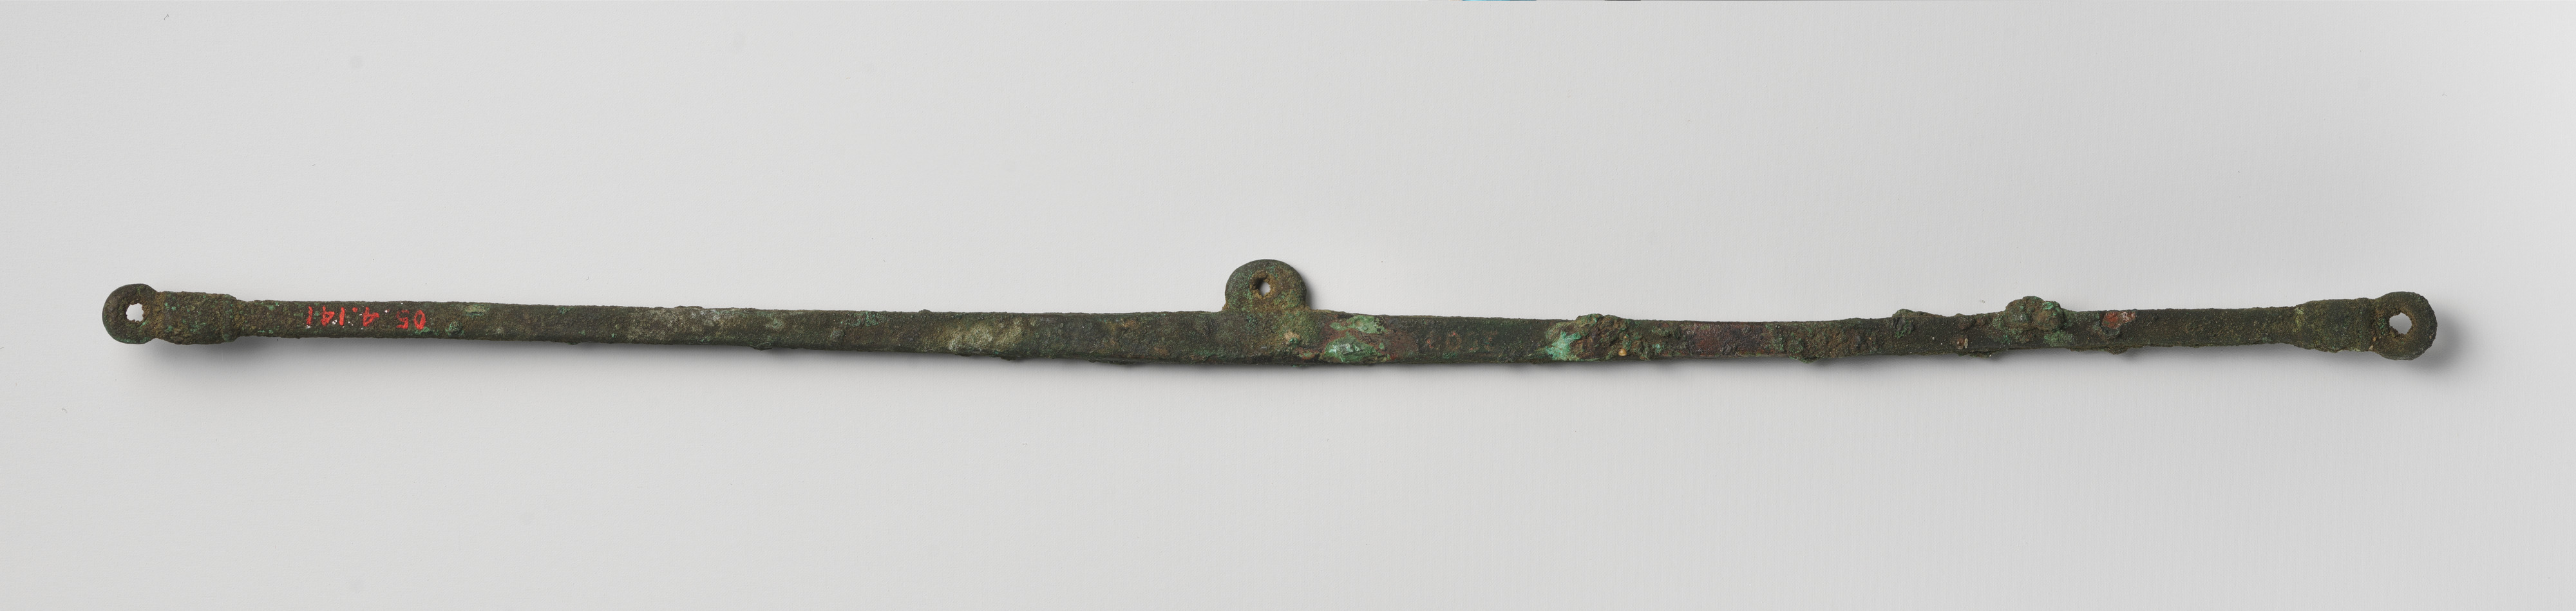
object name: scale, beam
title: Beam from a scale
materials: copper alloy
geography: egypt